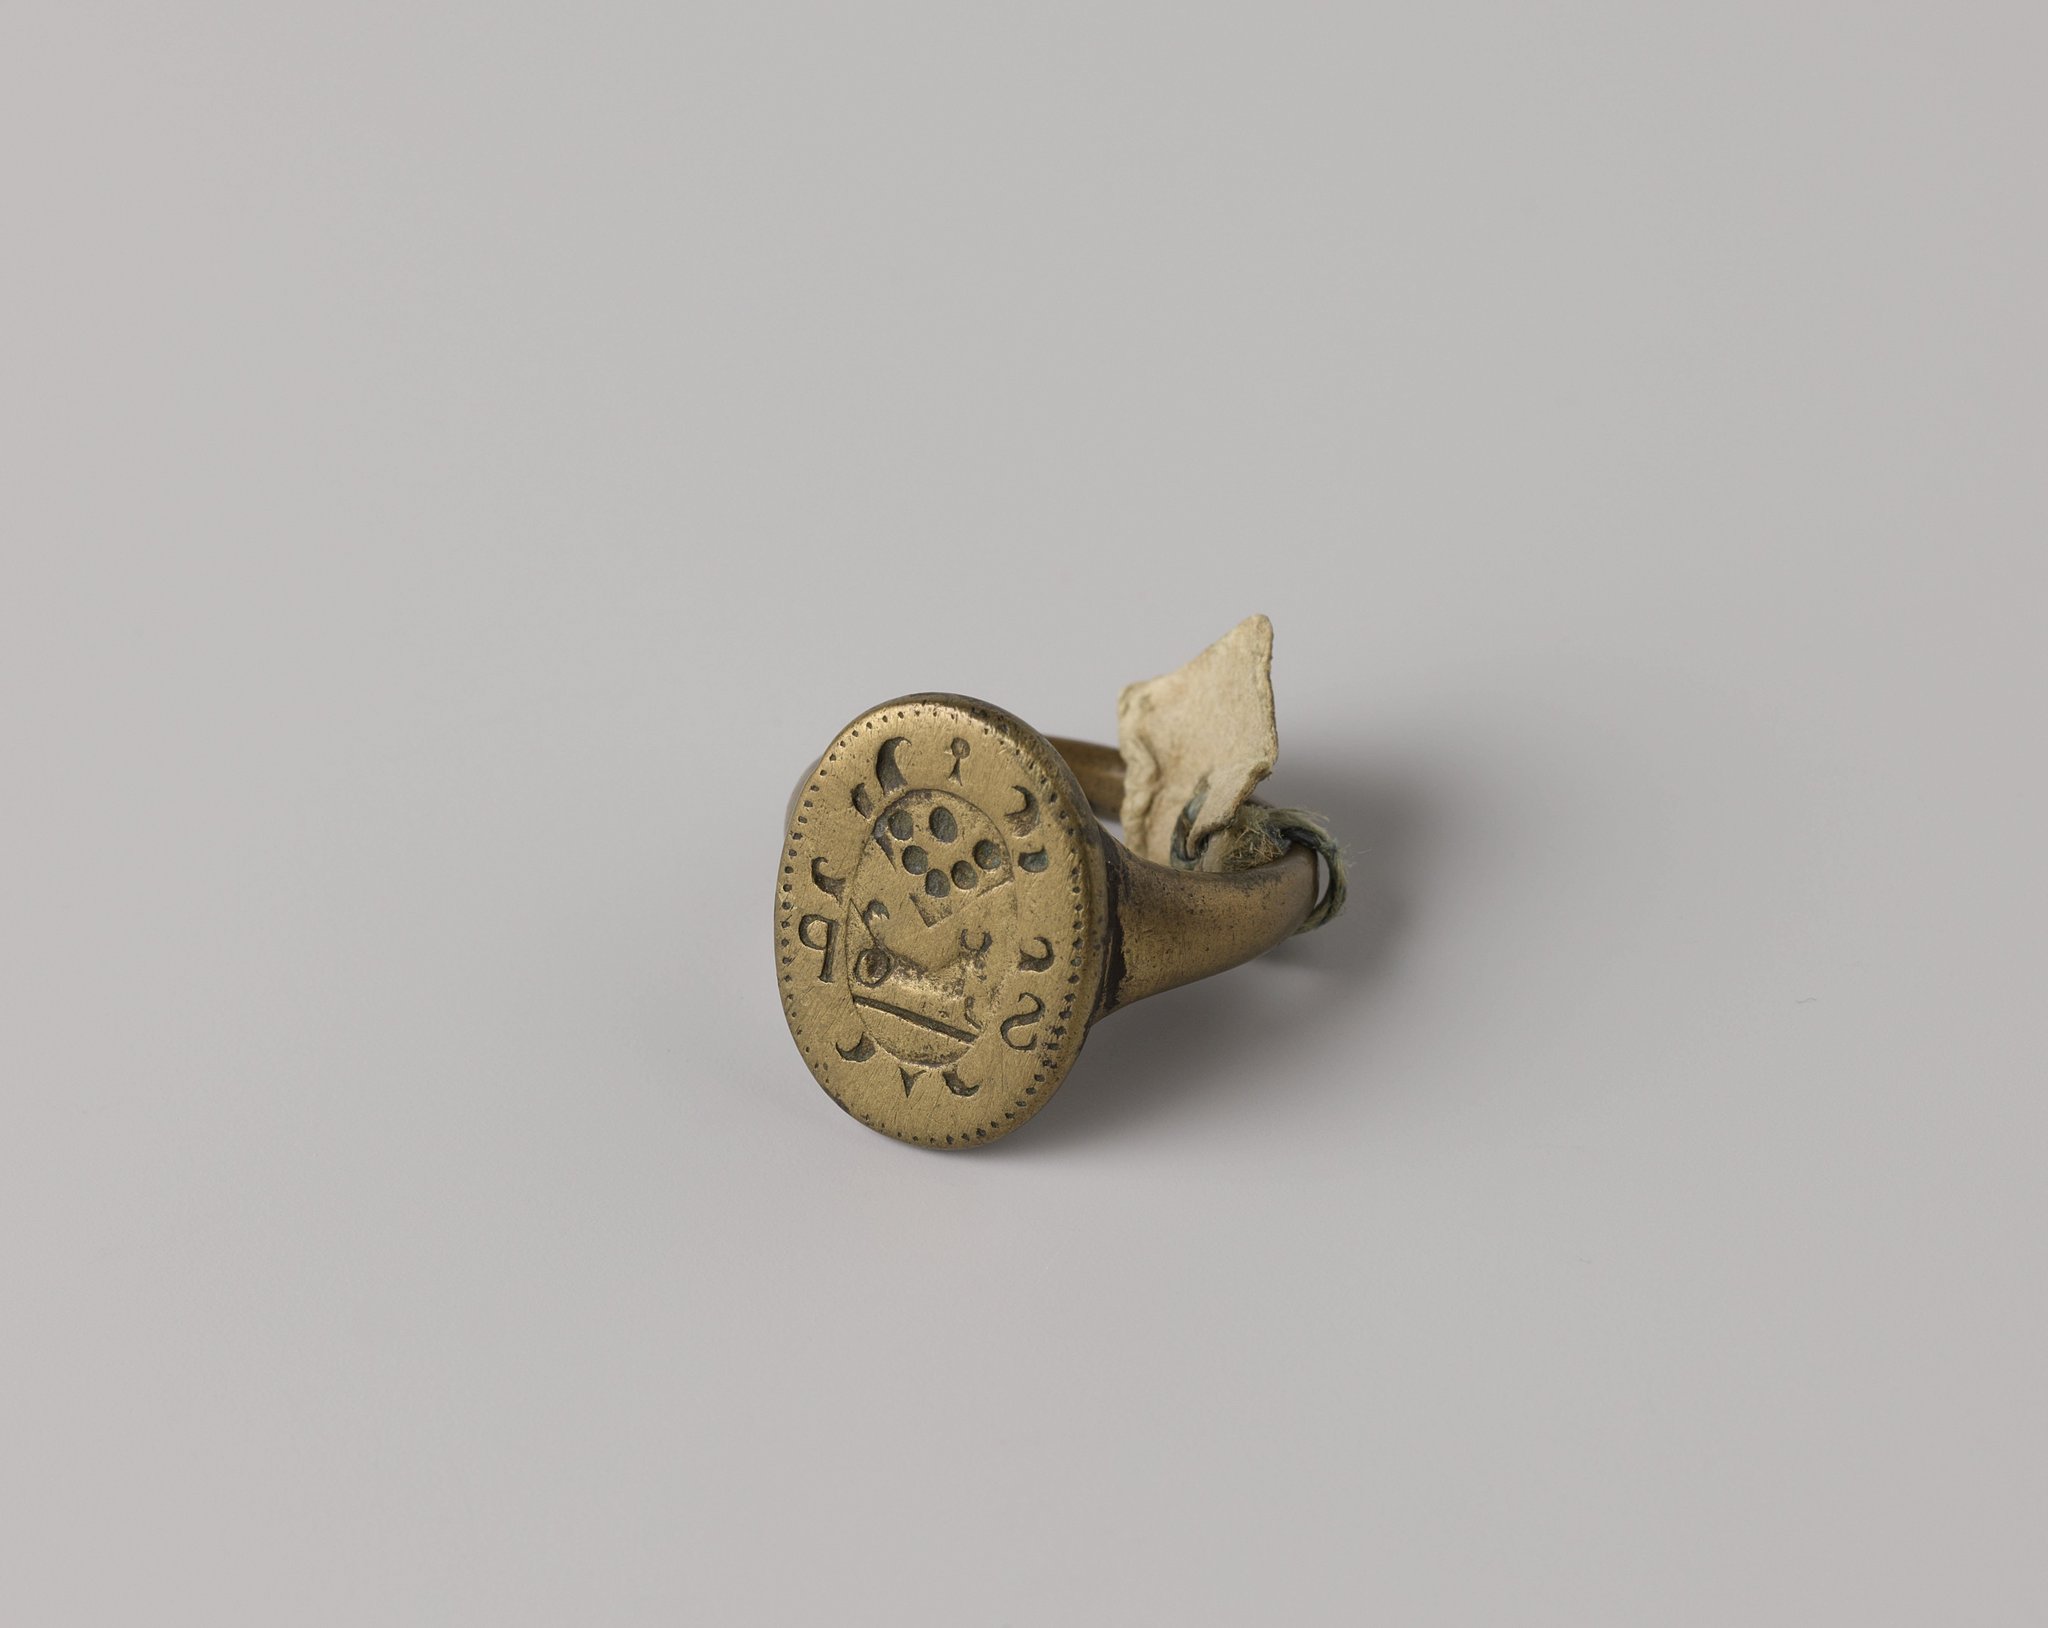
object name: vingerring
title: Zegelring waarop wapen en SP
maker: Anonymous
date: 1000-1900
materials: copper, leather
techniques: engraving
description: Ring met ovalen stempel. Binnen een parelrand staat een ovaal wapen afgebeeld waarachter verschillende dorentjes uitsteken, boven vier en onder drie. Links staat een omgedraaide P en rechts een omgedraaide S, boven een miniscuul driehoekje waarboven een bolletje. Boven in het schild is een driehoek uitgesneden waarin zes bolletjes, onder de driehoek een gehoornde slang met gekrulde staart en een hoorn voor hem. Daaronder een streep.